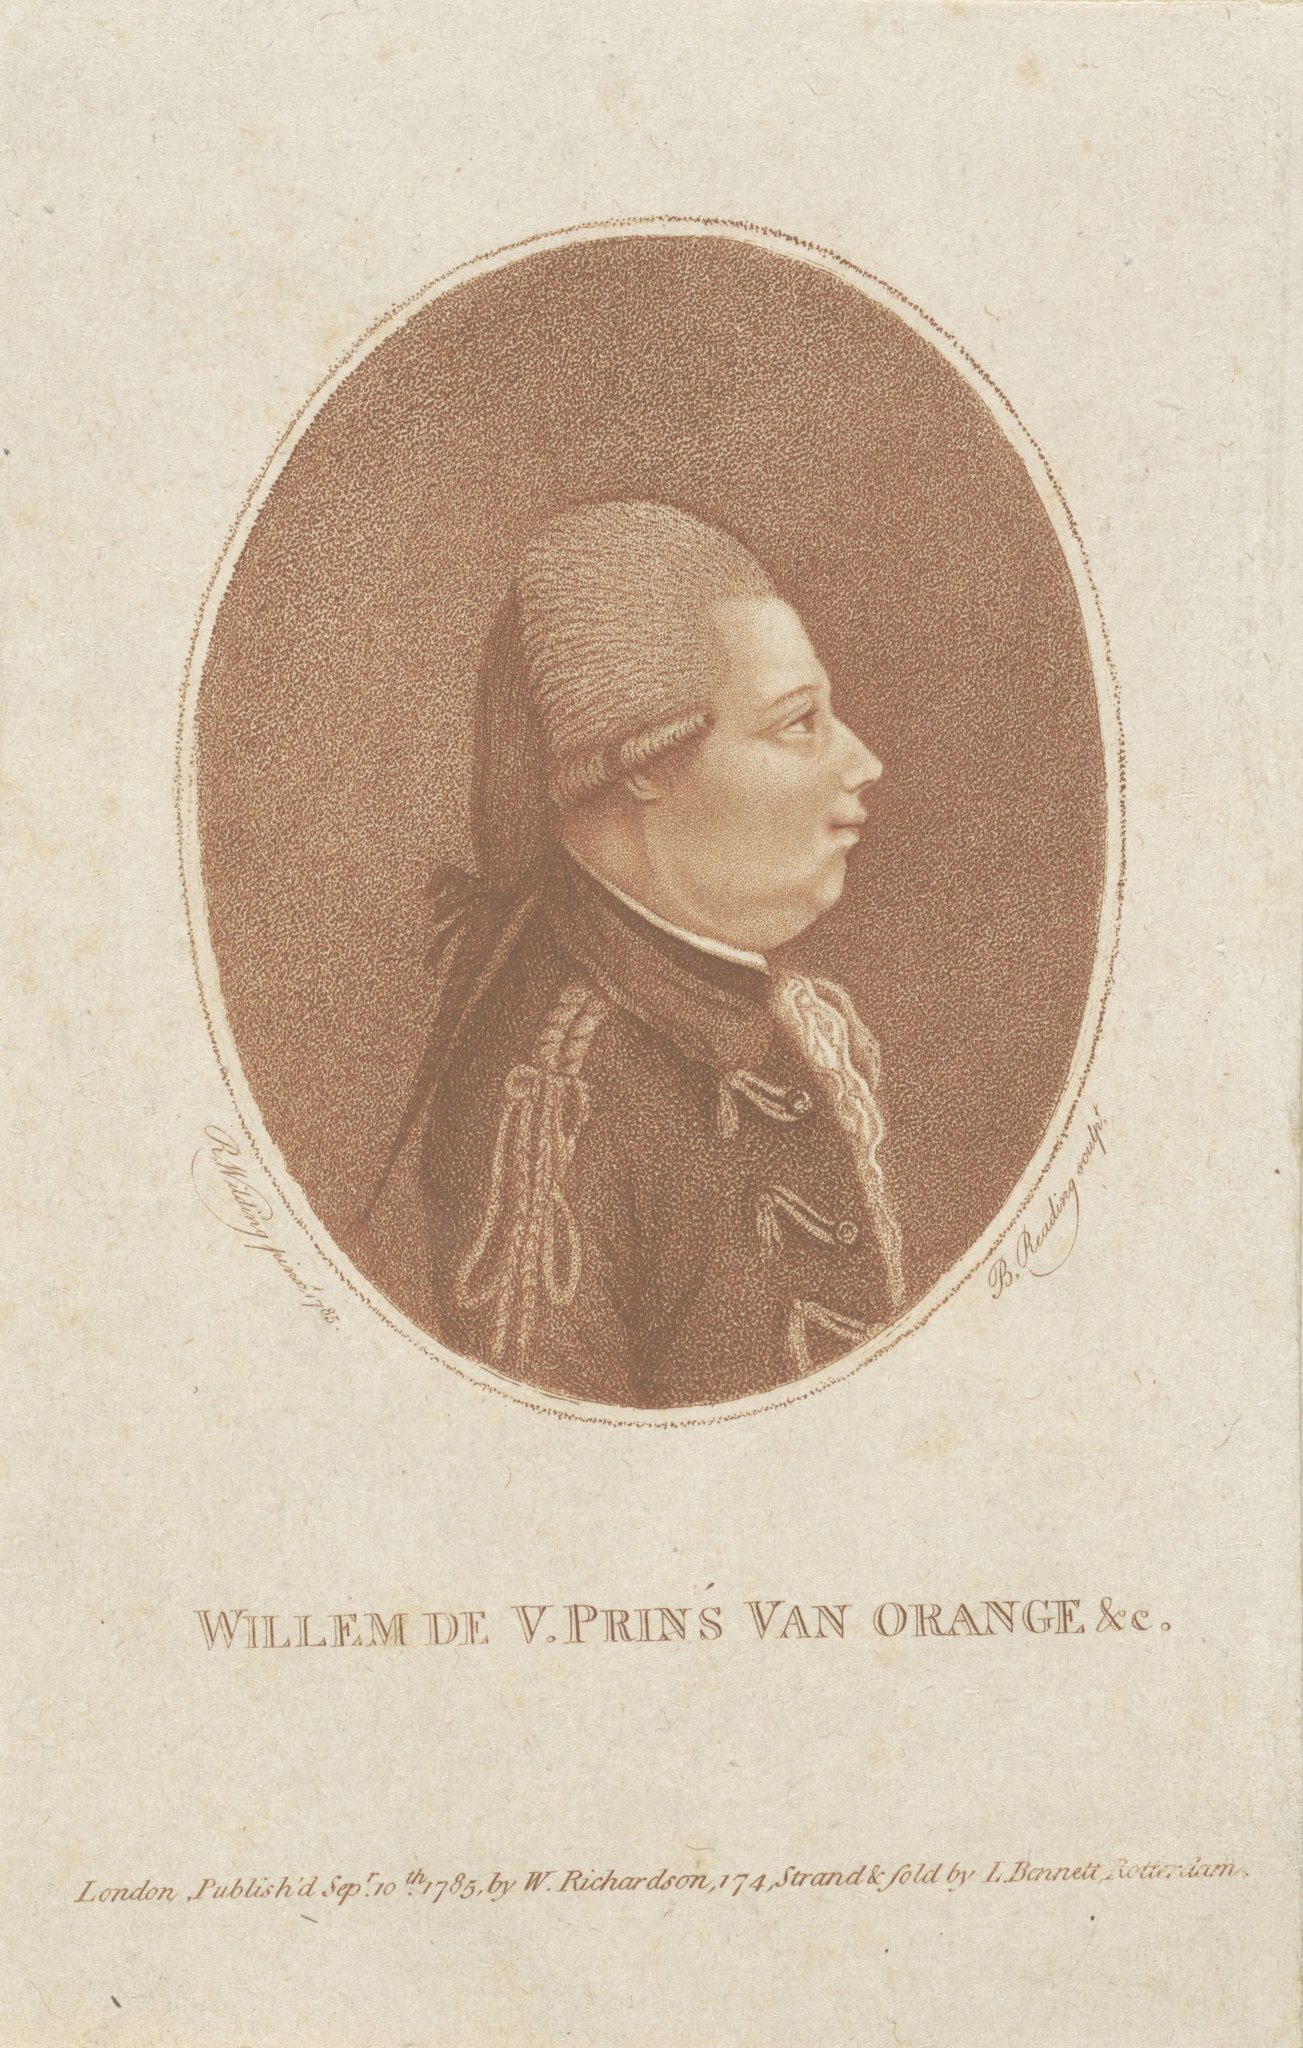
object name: print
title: Portret van Willem V, prins van Oranje-Nassau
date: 1785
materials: paper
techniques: engraving, etching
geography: london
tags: the hague, william v (prince of orange)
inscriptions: date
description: De hier vermelde titel verwijst naar de hoogst verkregen titel van de geportretteerde, niet per se naar de titel die de geportretteerde op deze voorstelling draagt.